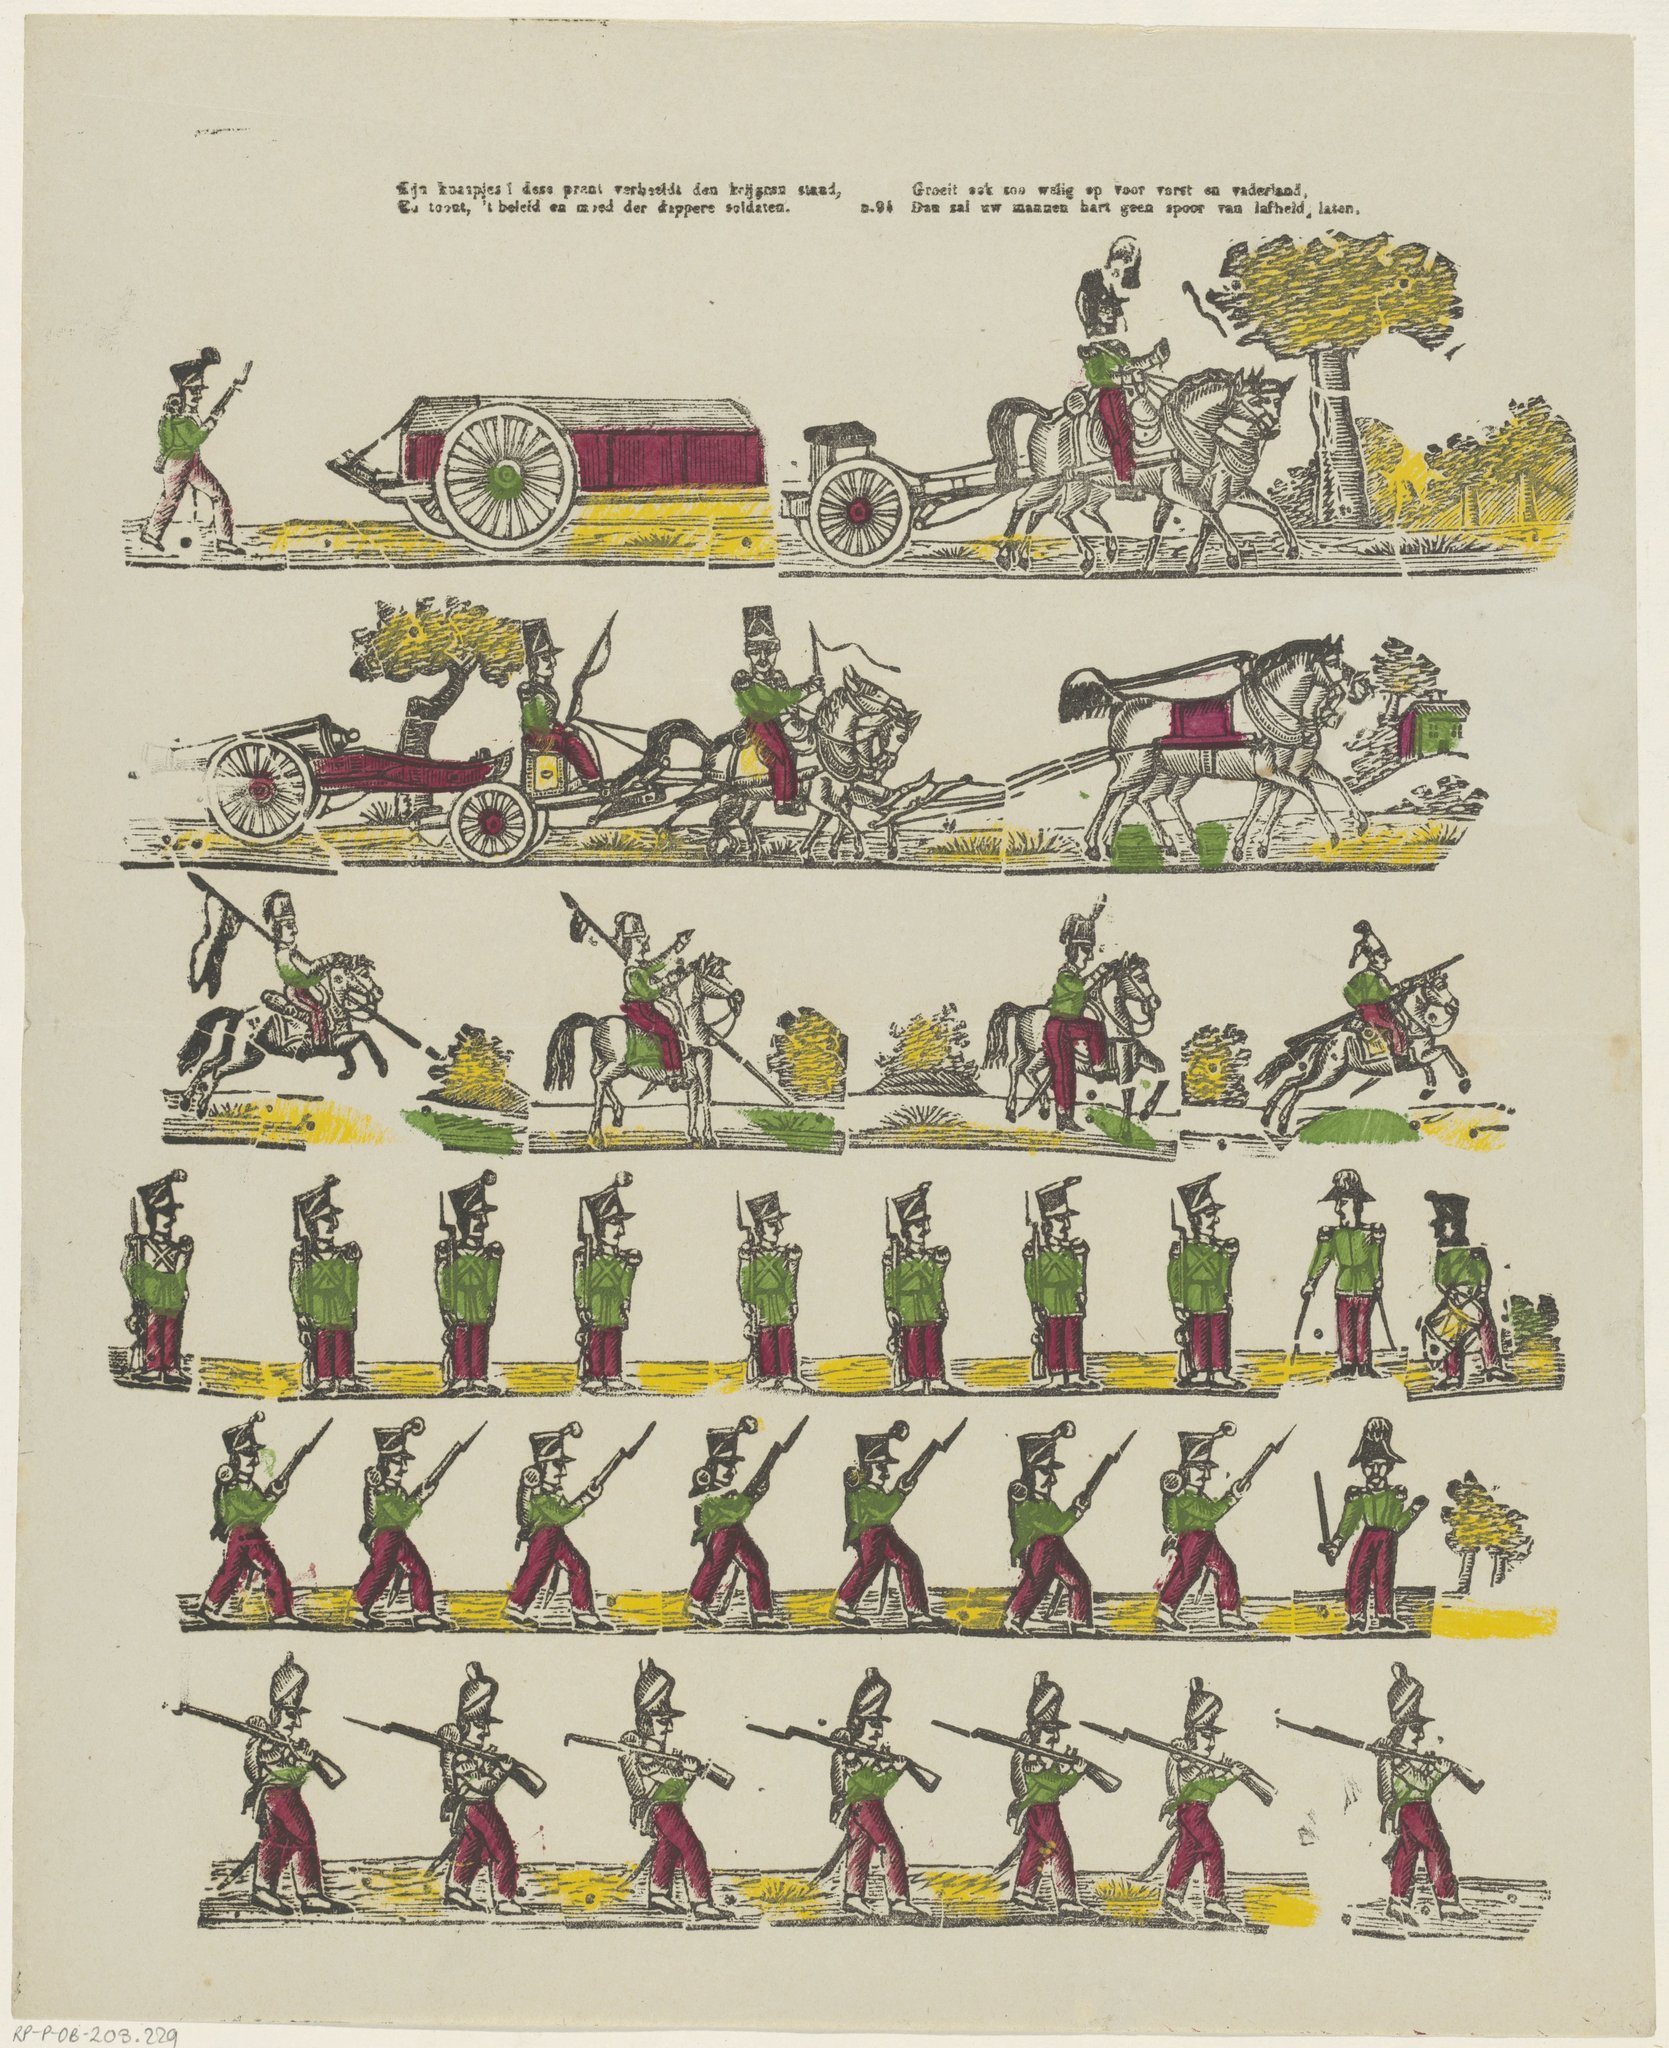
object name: popular print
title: Myn knaepjes! deze prent verbeeldt den krijgeren stand, / En toont, 't beleid en moed der dappere soldaten. / Groeit ook zoo walig op voor vorst en vaderland, / Dan zal uw mannen hart geen spoor van lafheid laten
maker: Anonymous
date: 1833-1900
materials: paper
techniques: colour, letterpress printing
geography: netherlands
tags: warfare; military affairs (+ cavalry, horsemen), the soldier; the soldier's life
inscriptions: collector's mark: Lugt 2760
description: Blad met 6 rijen met voorstellingen van militairen, bijvoorbeeld militairen te paard en voetsoldaten. Genummerd midden boven: n. 94.